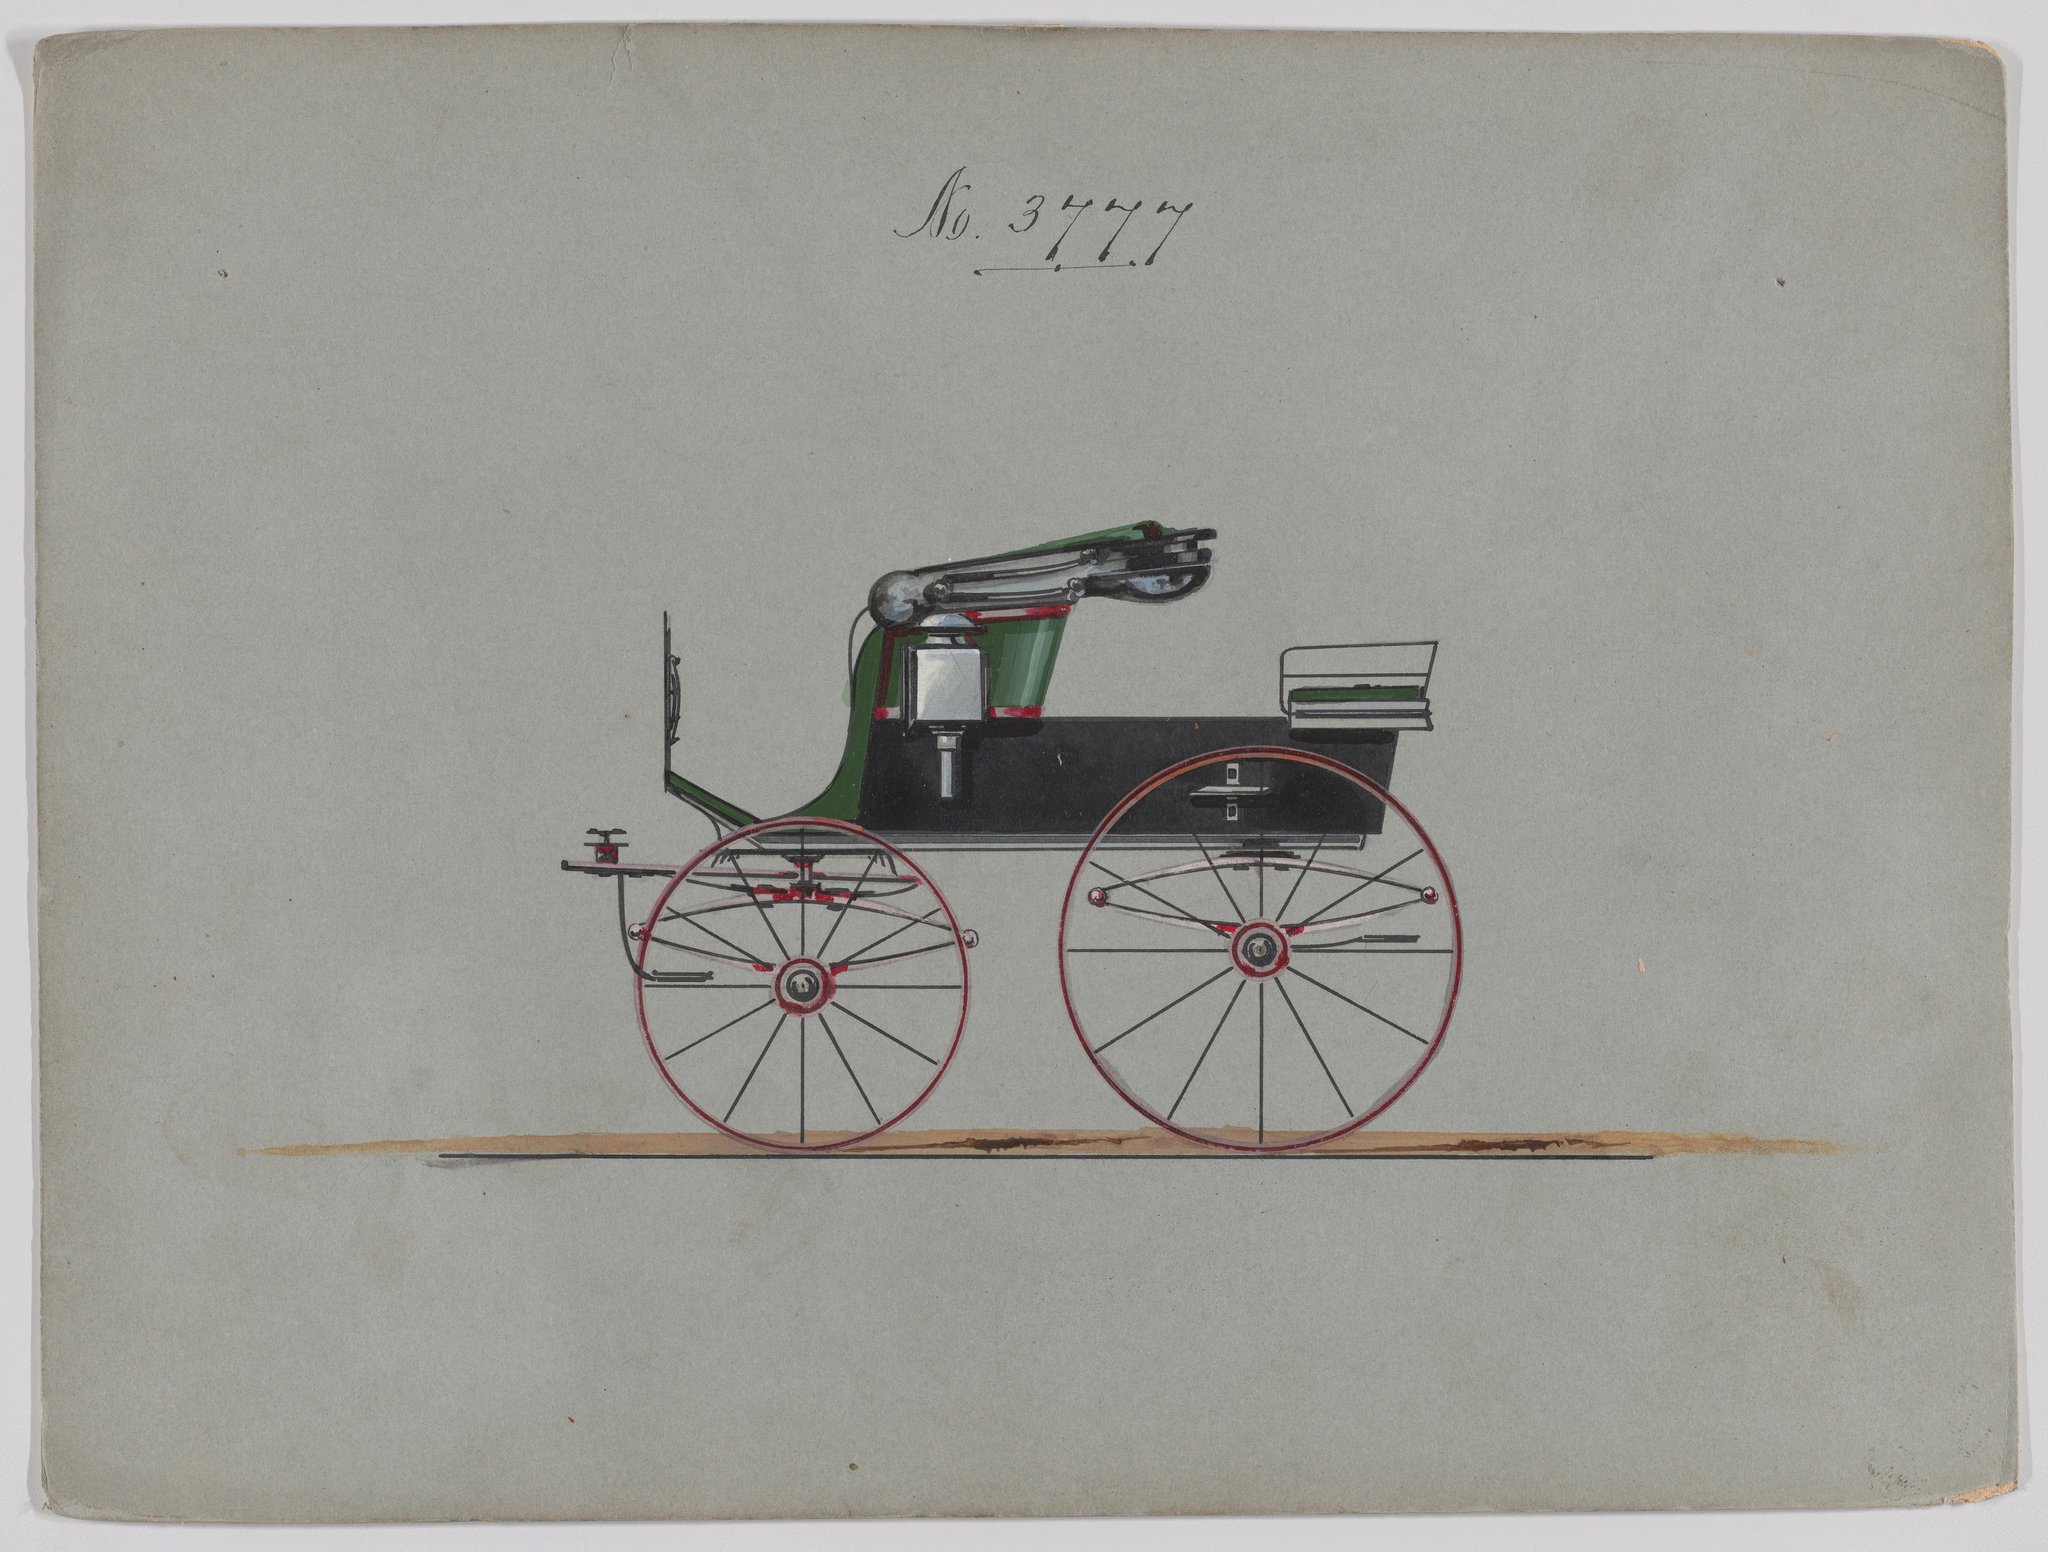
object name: drawing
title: Design for Stanhope Phaeton, no. 3777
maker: brewster & co.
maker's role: manufacturer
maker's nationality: american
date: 1882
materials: gouache, graphite, ink, watercolor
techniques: pen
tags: carriages